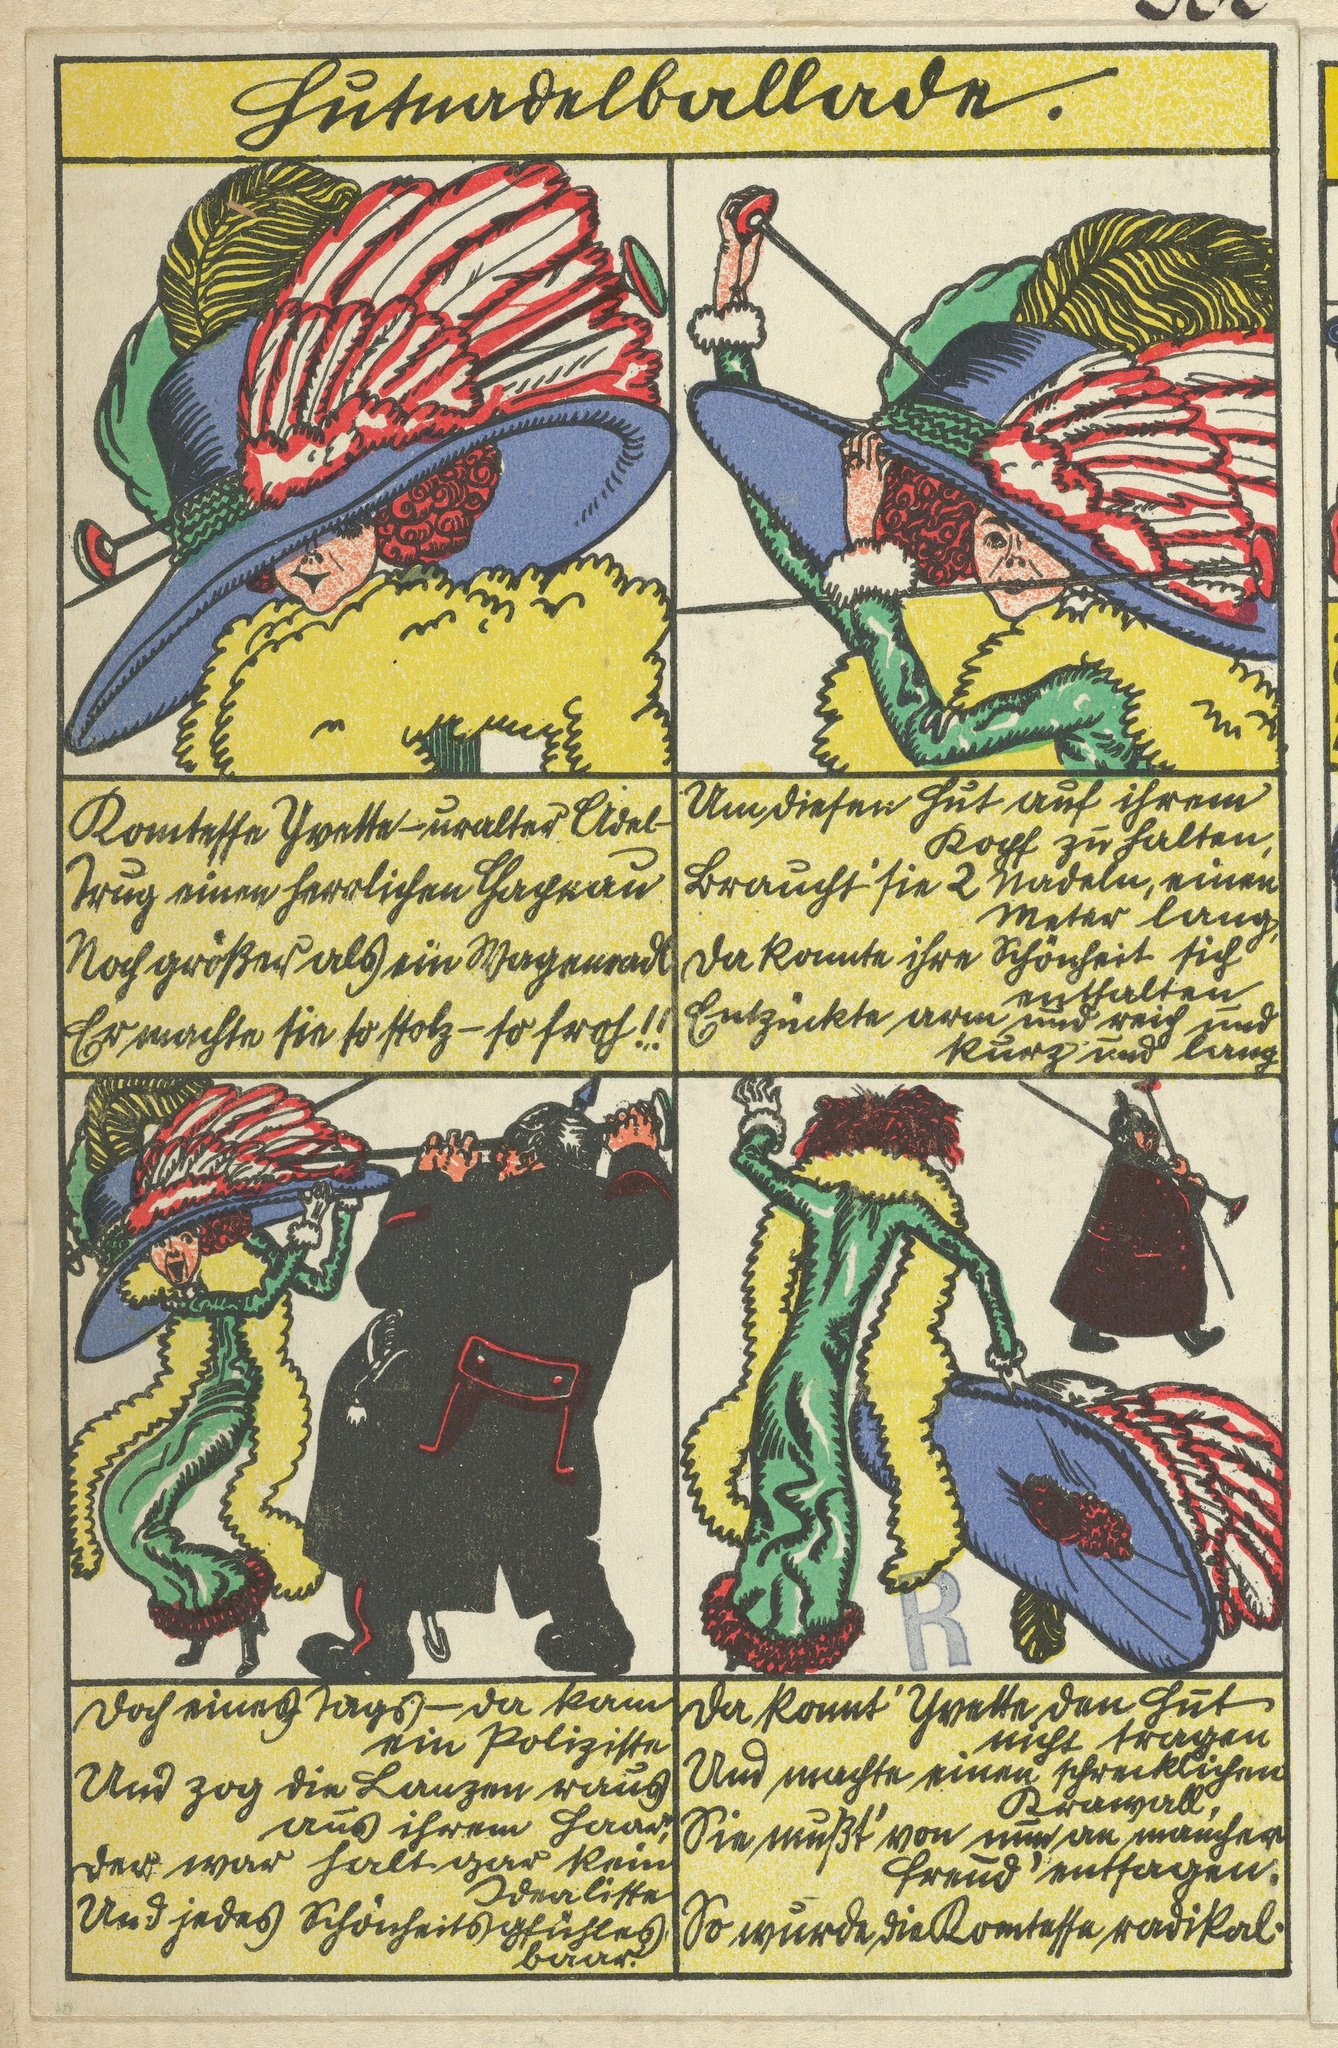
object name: print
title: Hatpin Ballad (Hutnadelballade)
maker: moriz jung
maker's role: artist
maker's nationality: austrian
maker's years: 1885-1915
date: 1911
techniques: lithograph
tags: satire,hats,pins